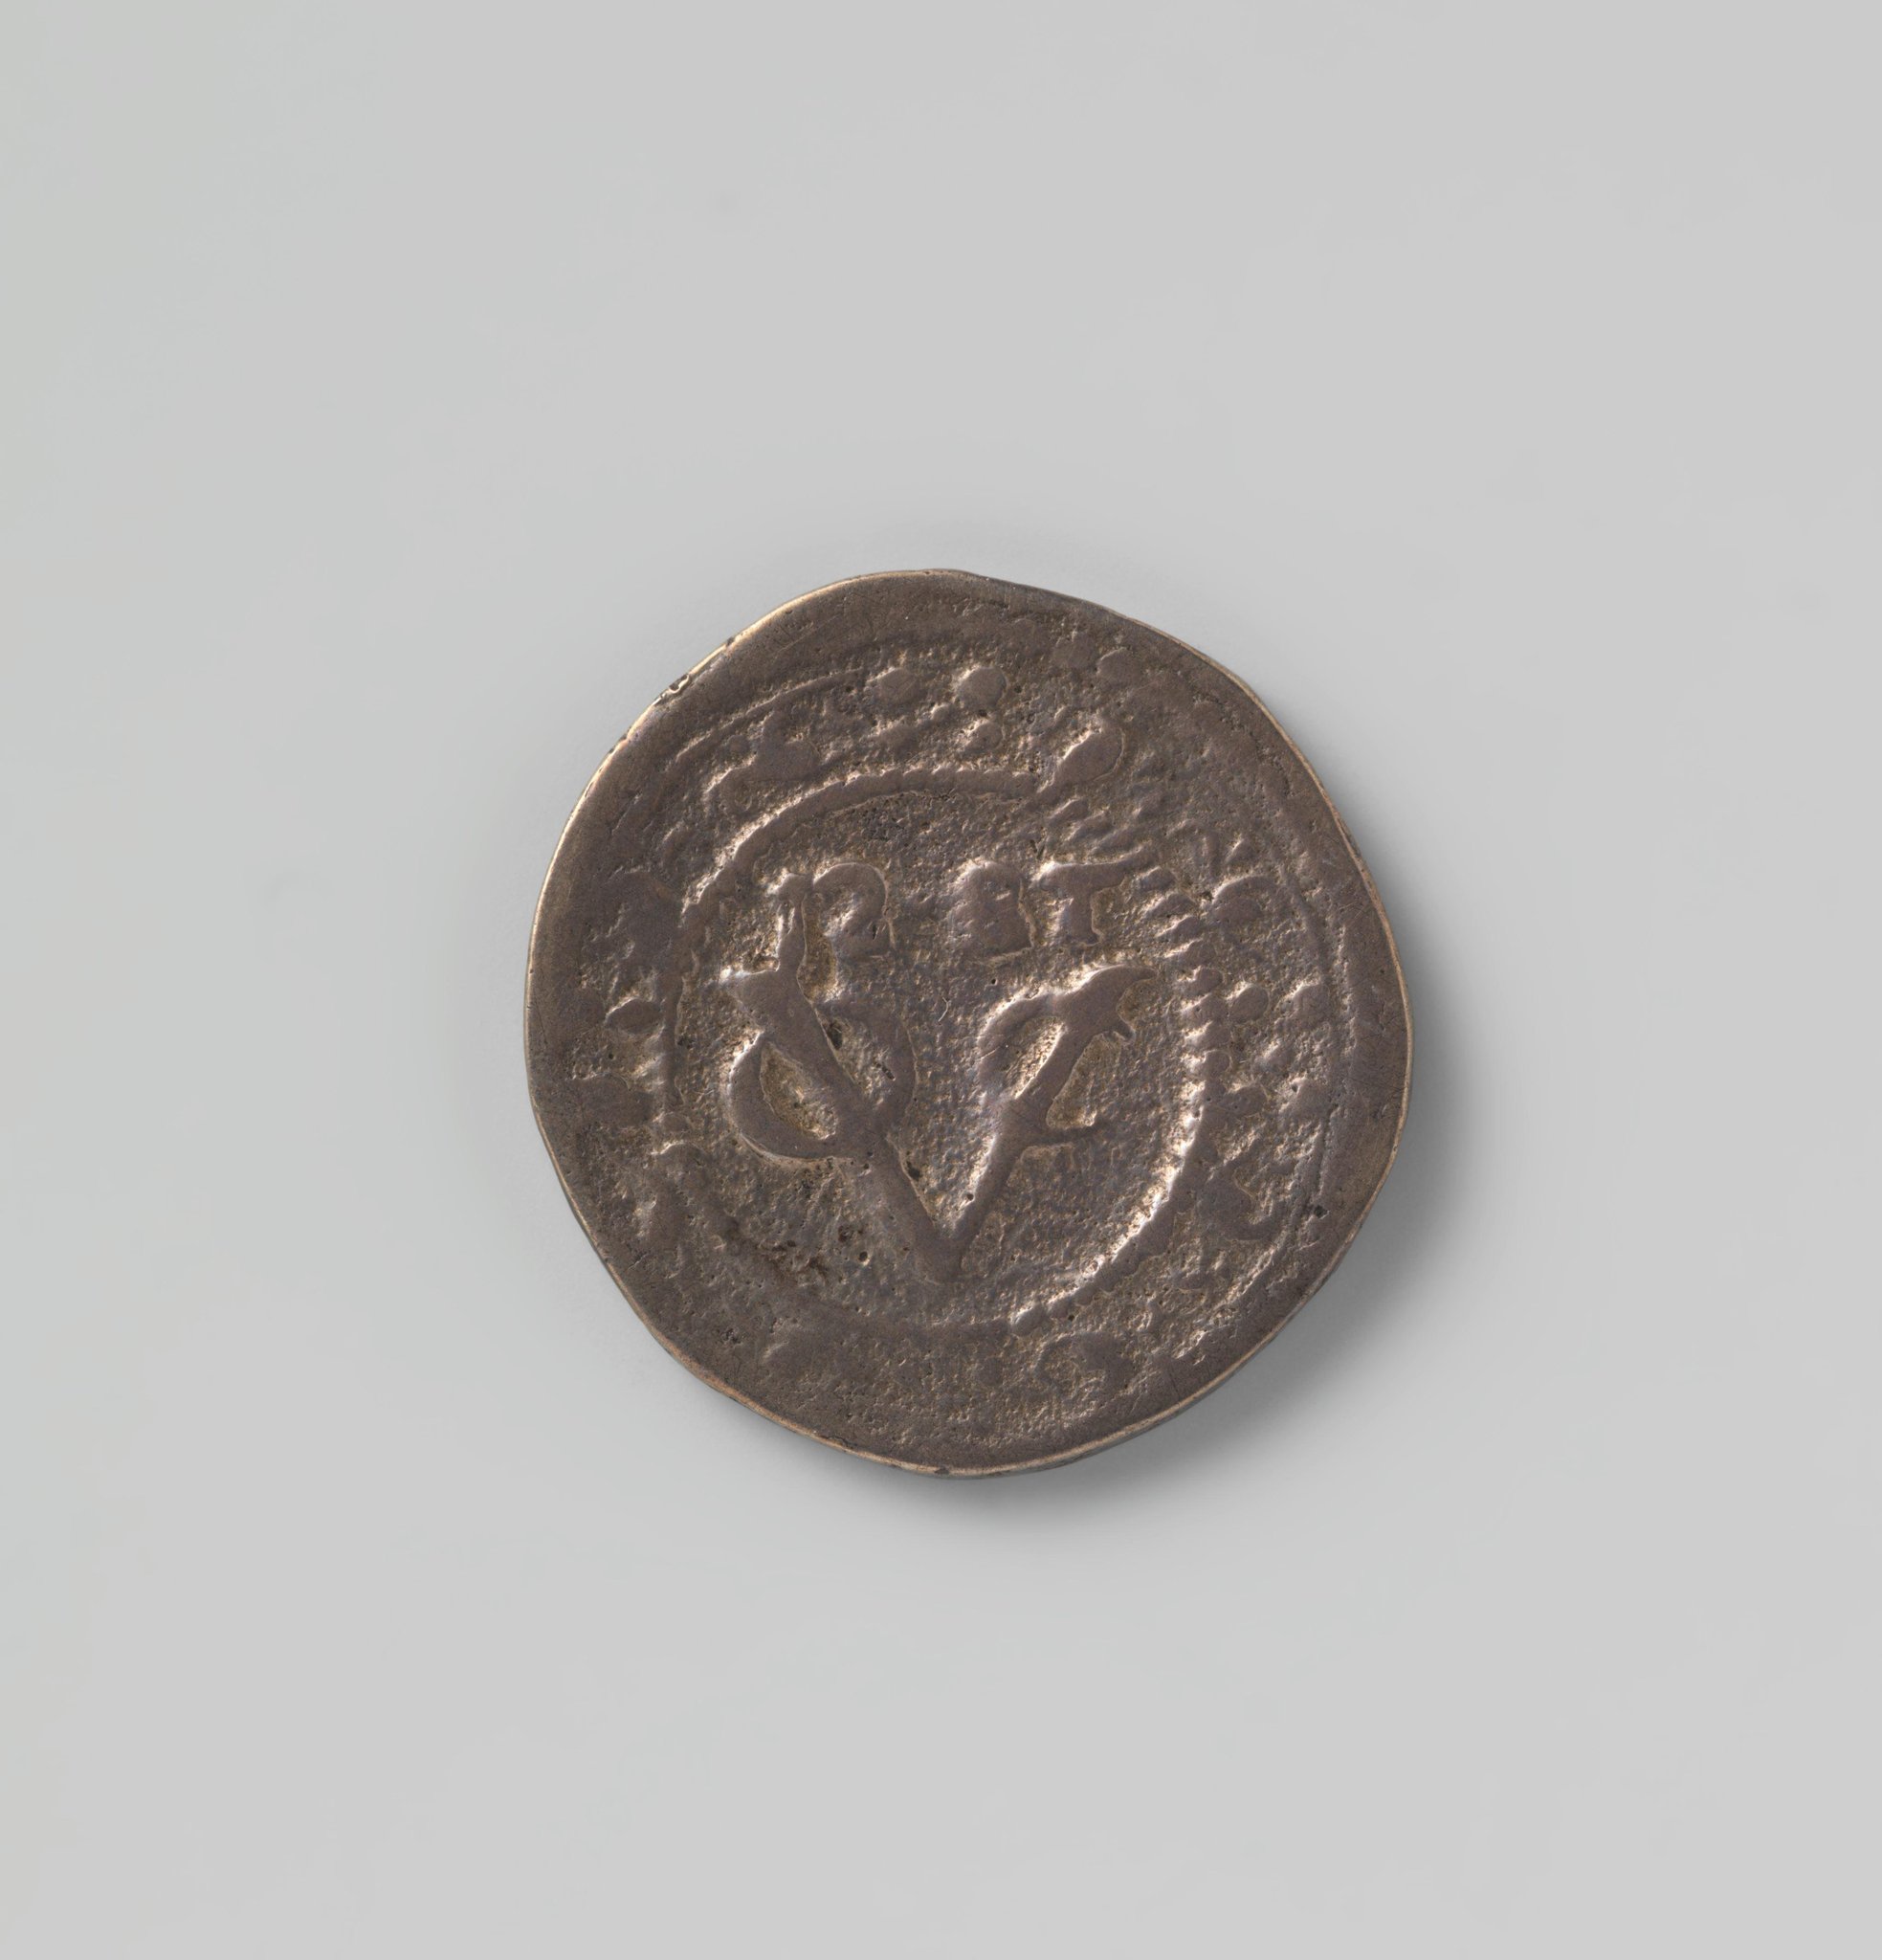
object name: twaalf stuiver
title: VOC, kwart kroon, 1645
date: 1645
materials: silver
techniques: striking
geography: batavia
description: Zilveren noodmunt. Voorzijde: naar beneden gericht zwaard met lauwerkrans. Jaartal in omschrift. Keerzijde: monogram van de VOC, waarboven waarde-aanduiding 12 st. Gladde rand.